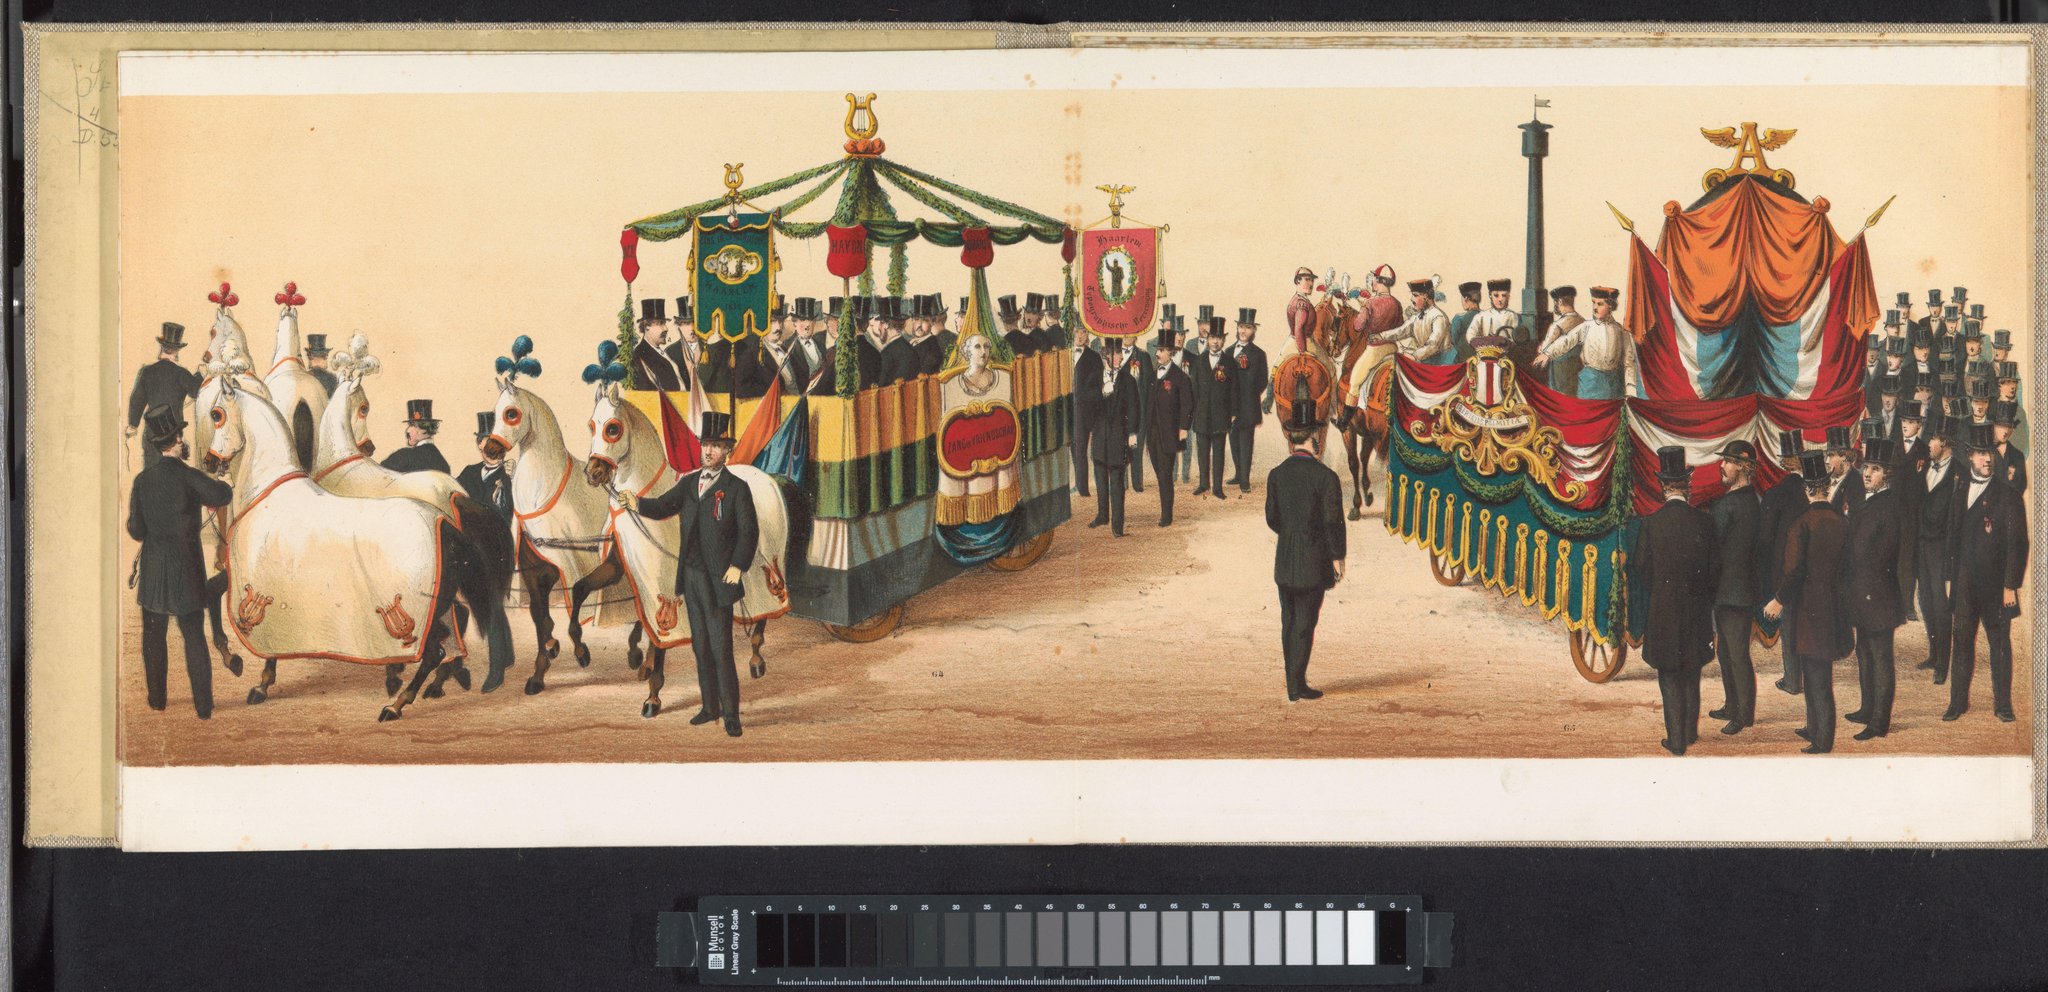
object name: print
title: Optocht te Haarlem, 1872 (plaat 9)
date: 1872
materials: paper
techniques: chromolithography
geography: haarlem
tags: festivities on events of national importance (+ parade, pageant, cavalcade ~ festive activities), costumes used in pageants, haarlem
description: Feestelijke optocht gehouden te Haarlem tijdens de Aprilfeesten op 1 april 1872 ter gelegenheid van het 300-jarige onafhankelijkheid van Nederland. Negende plaat met de groepen genummerd 64-65. Onderdeel van de serie van twaalf aaneen geplakte bladen.